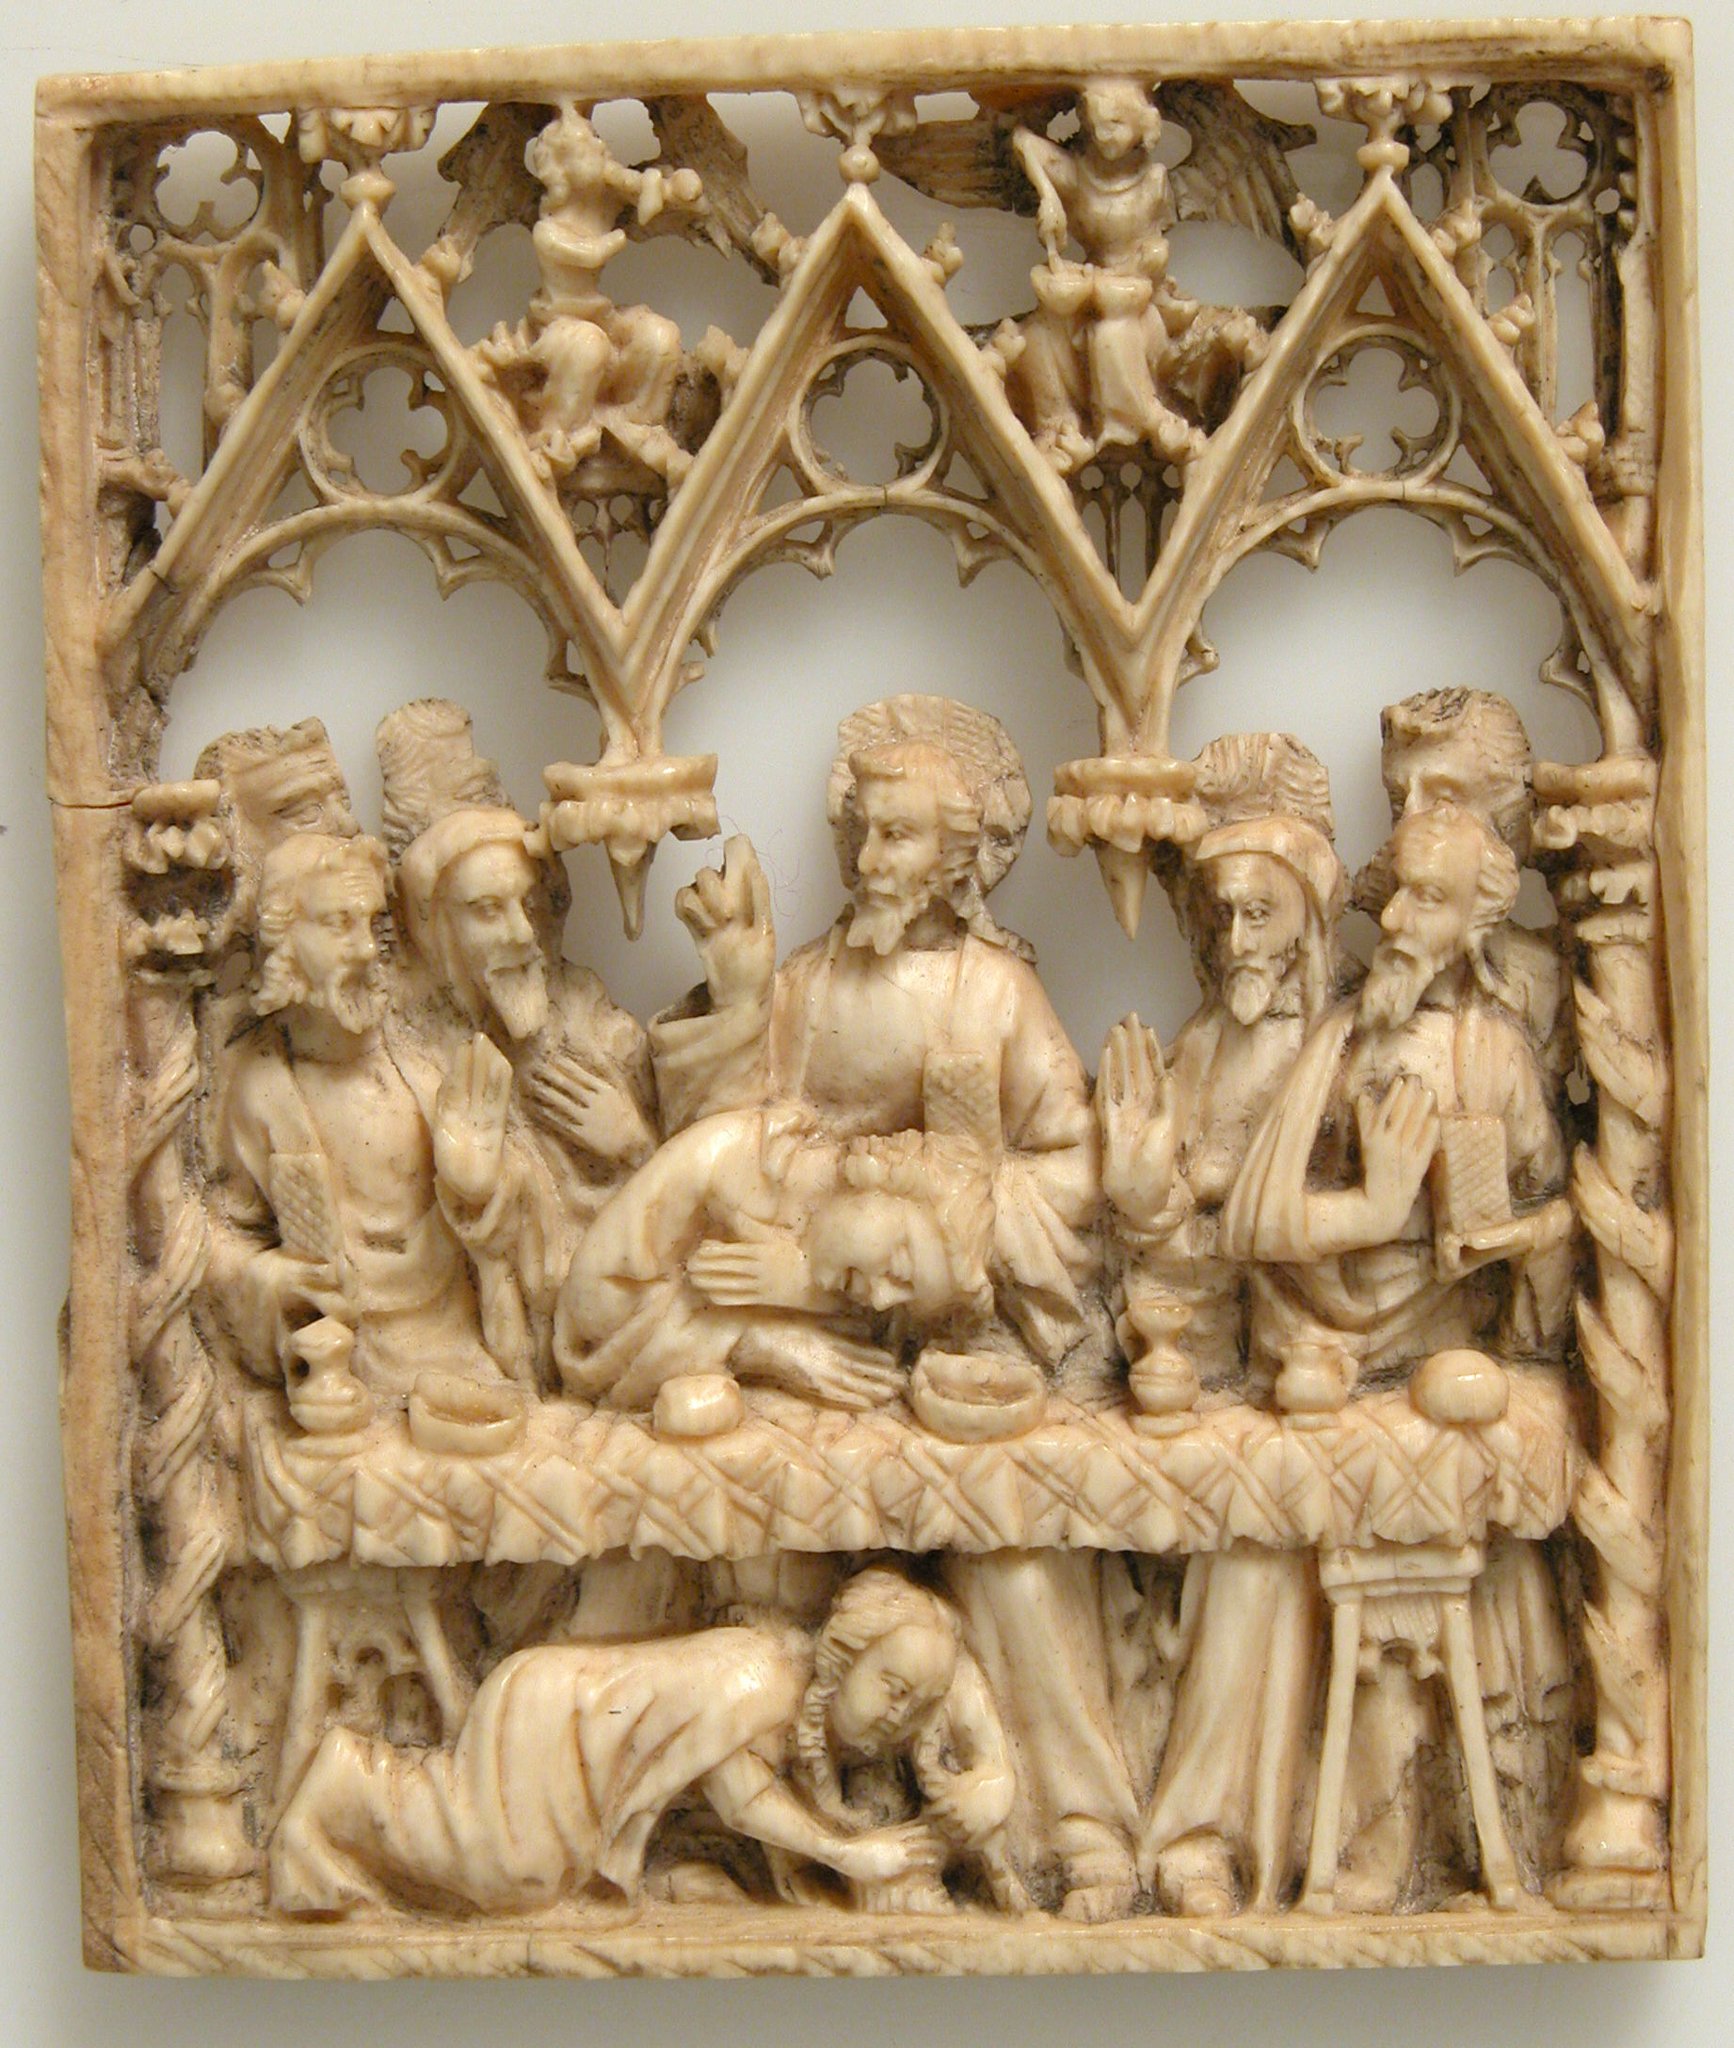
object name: plaque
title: Plaque with the Last Supper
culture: british or french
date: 1401-1500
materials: ivory